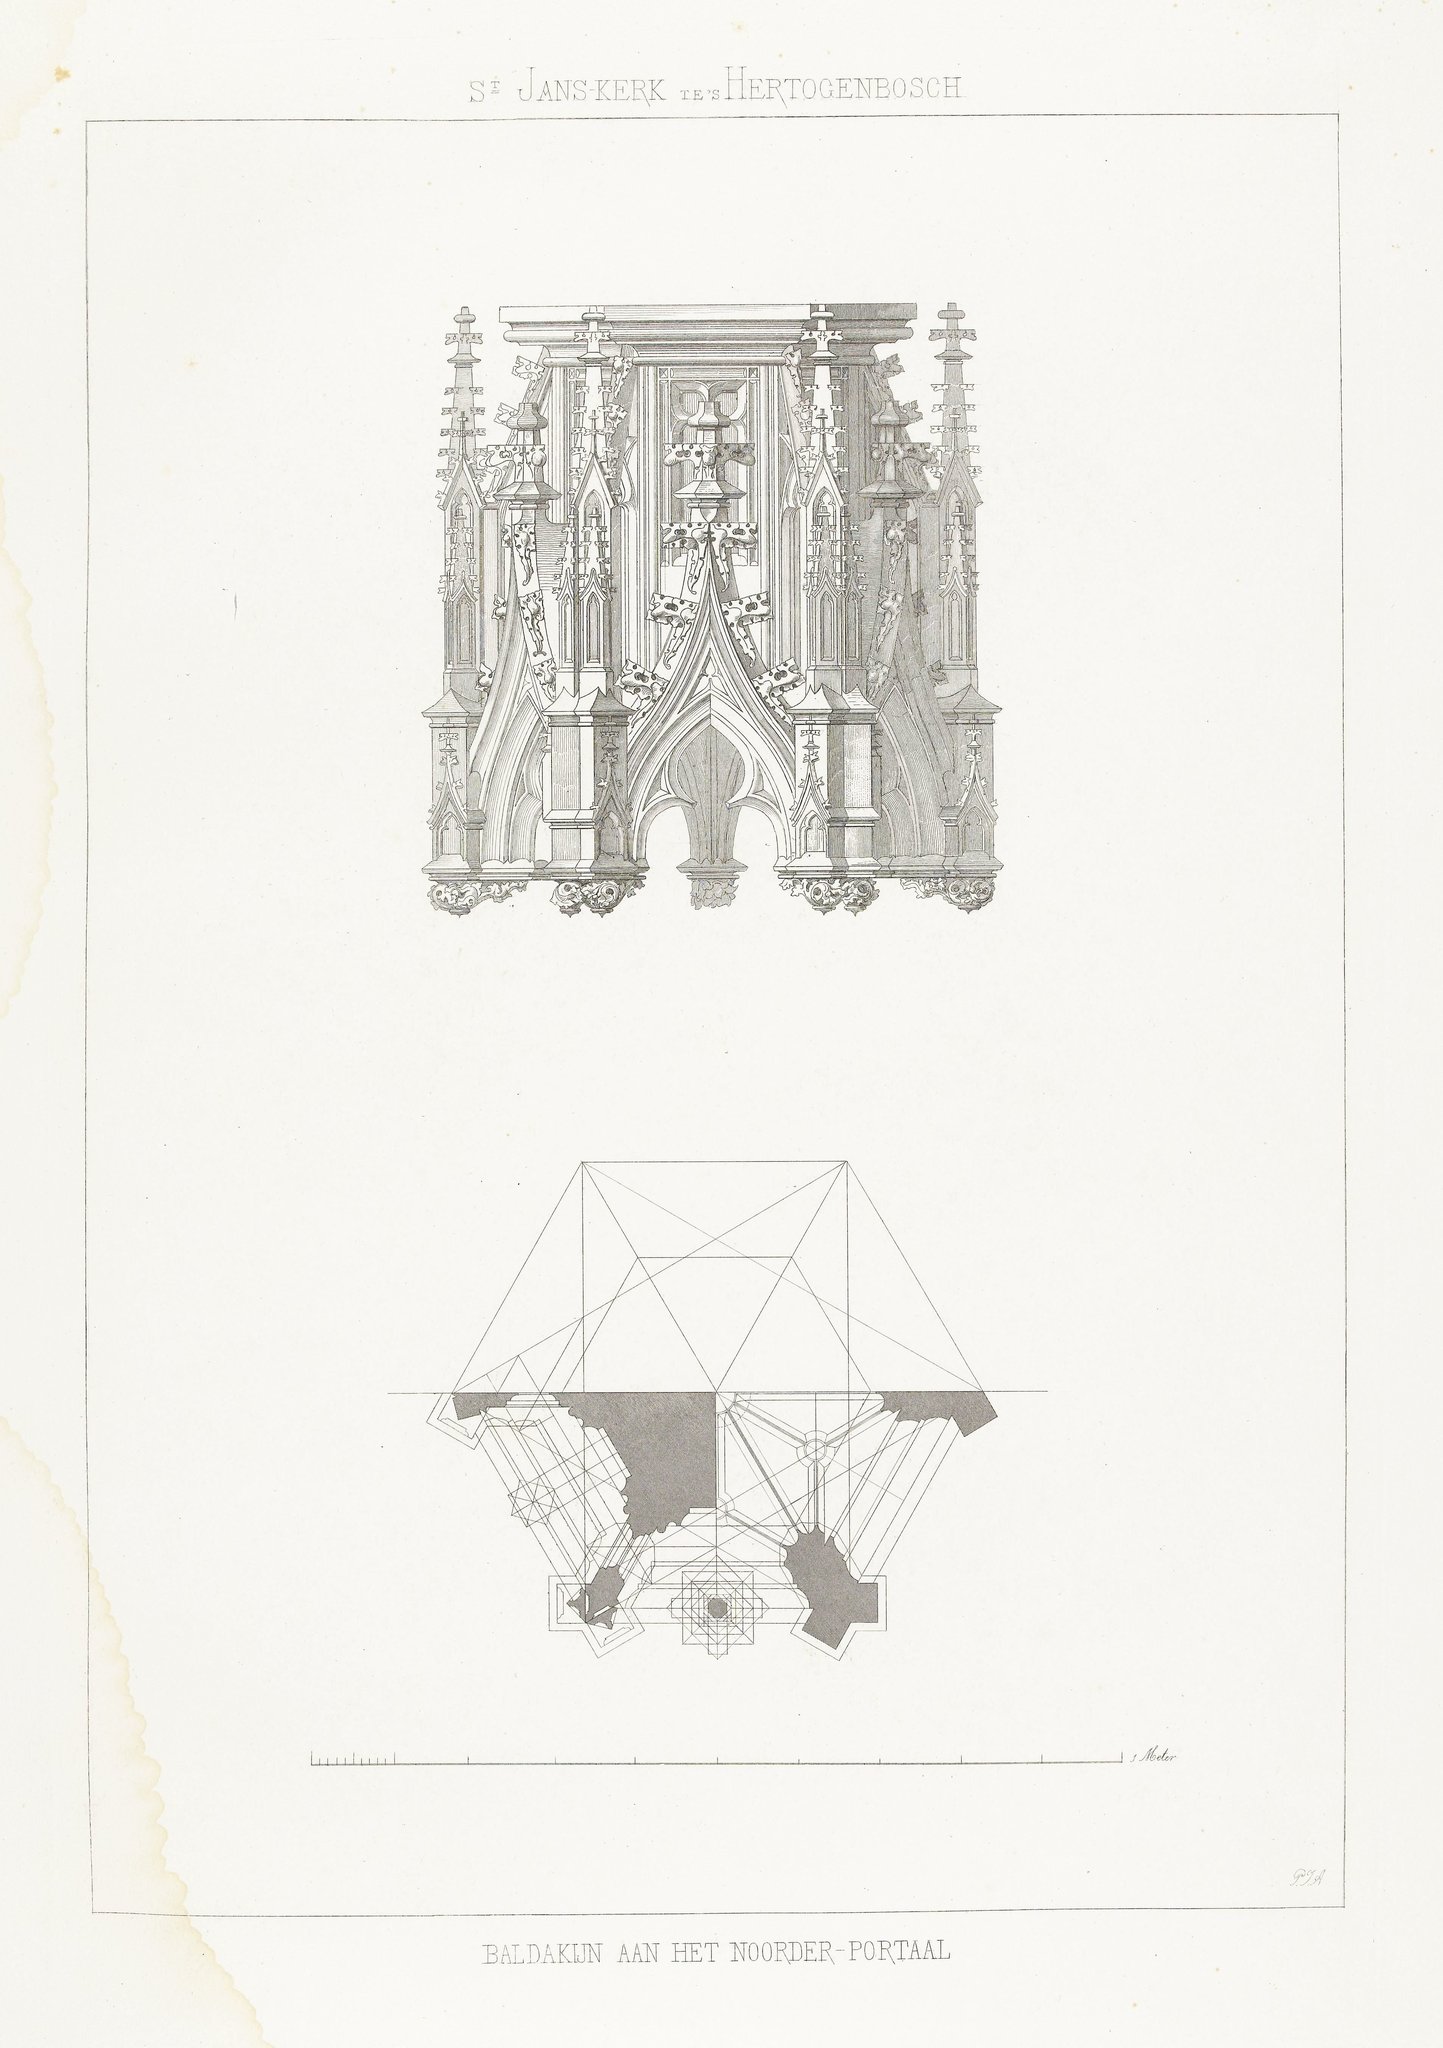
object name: print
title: Doorsnede en vooraanzicht van het baldakijn aan het noordportaal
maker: petrus johannes arendzen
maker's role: draughtsman, print maker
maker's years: 1846-1932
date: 1875-1895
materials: paper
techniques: engraving, etching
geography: netherlands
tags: sint-janskathedraal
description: Waarschijnlijk afkomstig uit: J.C.A. Hezenmans, De St. Jans-kerk te 's-Hertogenbosch, uitg. door het Provinciaal Genootschap voor Kunsten en Wetenschappen in Noord-Brabant, 's-Hertogenbosch : Muller, [1895]